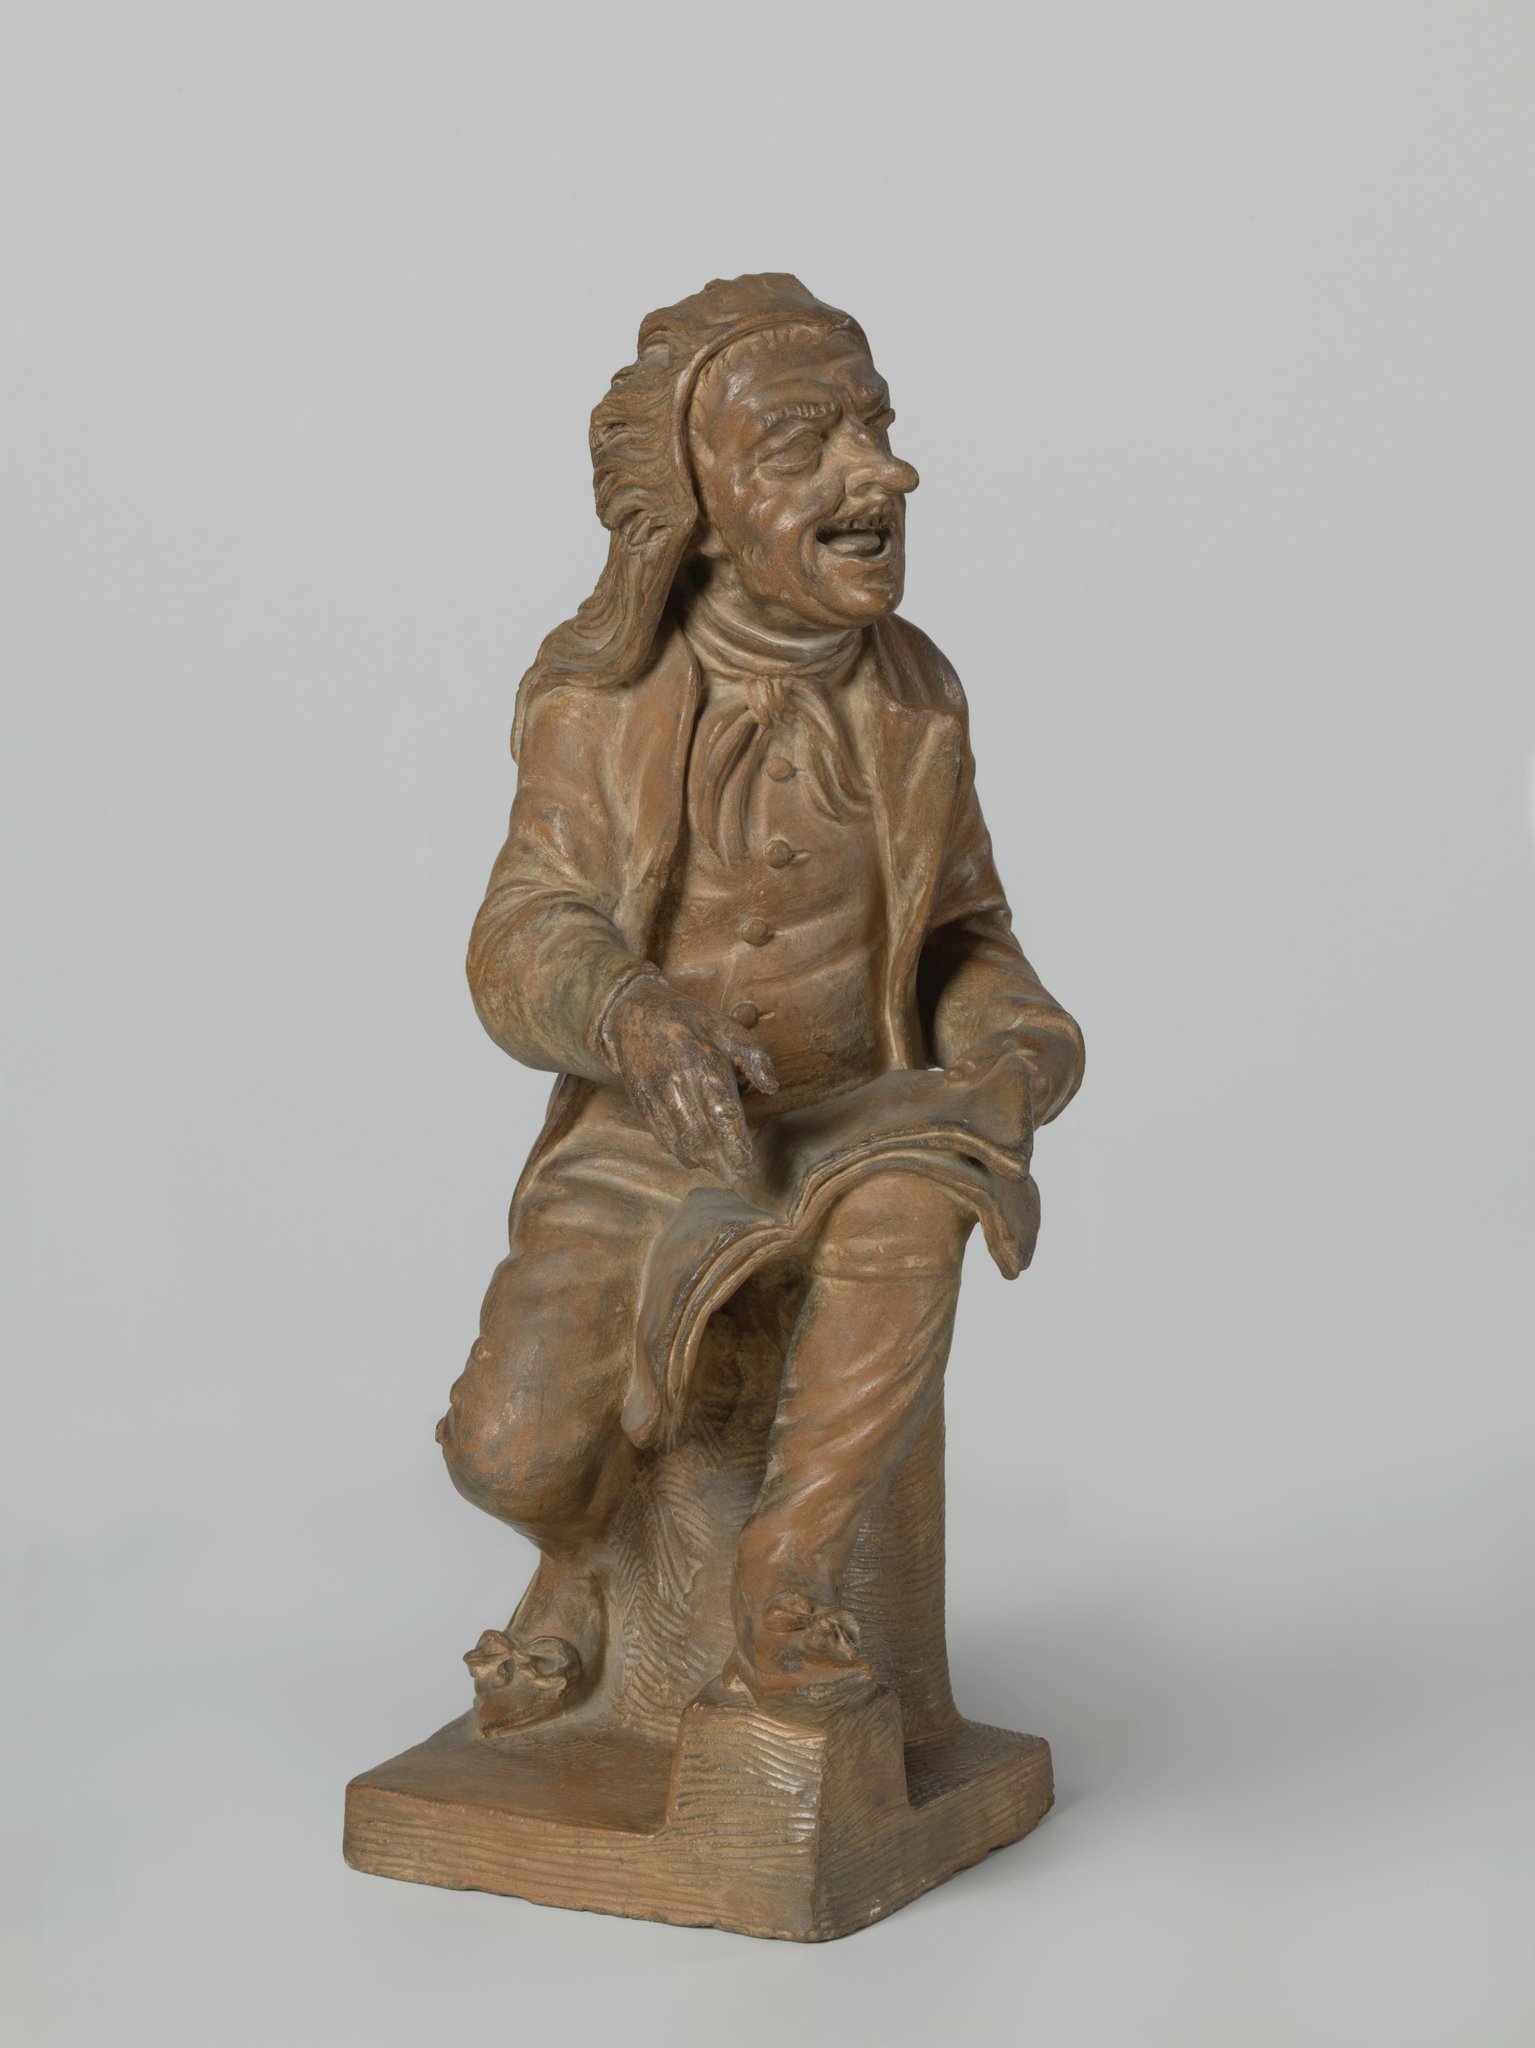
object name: sculpture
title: Zittende mannenfiguur met opengeslagen foliant op zijn knie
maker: Anonymous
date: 1770-1780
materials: terracotta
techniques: modeling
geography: italy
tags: caricatures (human types)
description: Hij zit op een ronde verhoging met de rechtervoet naar achteren geplaatst en de linker voor zich op een kleine, vierkante verhoging. Hij wendt zich naar rechts, houdt met de linkerhand enige bladzijden van de op een knie opengeslagen foliant en de ander er boven. De karikaturale kop heeft grote ogen, een lange, gebogen, scheve neus met een knobbel erop, een spitse kin en een geopende mond, waarin tong en tanden zichtbaar zijn. Op het hoofd staat een pruik met haar van teeërlei lengte, waarvan het langste tot op de rug hangt. Hij draagt een kort jasje over een dichtgeknoopt vest en om de hals een geknoopte doek; een korte broek, bij de knieën met een rij knoopjes gesloten, kousen, die gedraaid om de benen zitten en spits toelopende lage schoenen, waarop een strik.